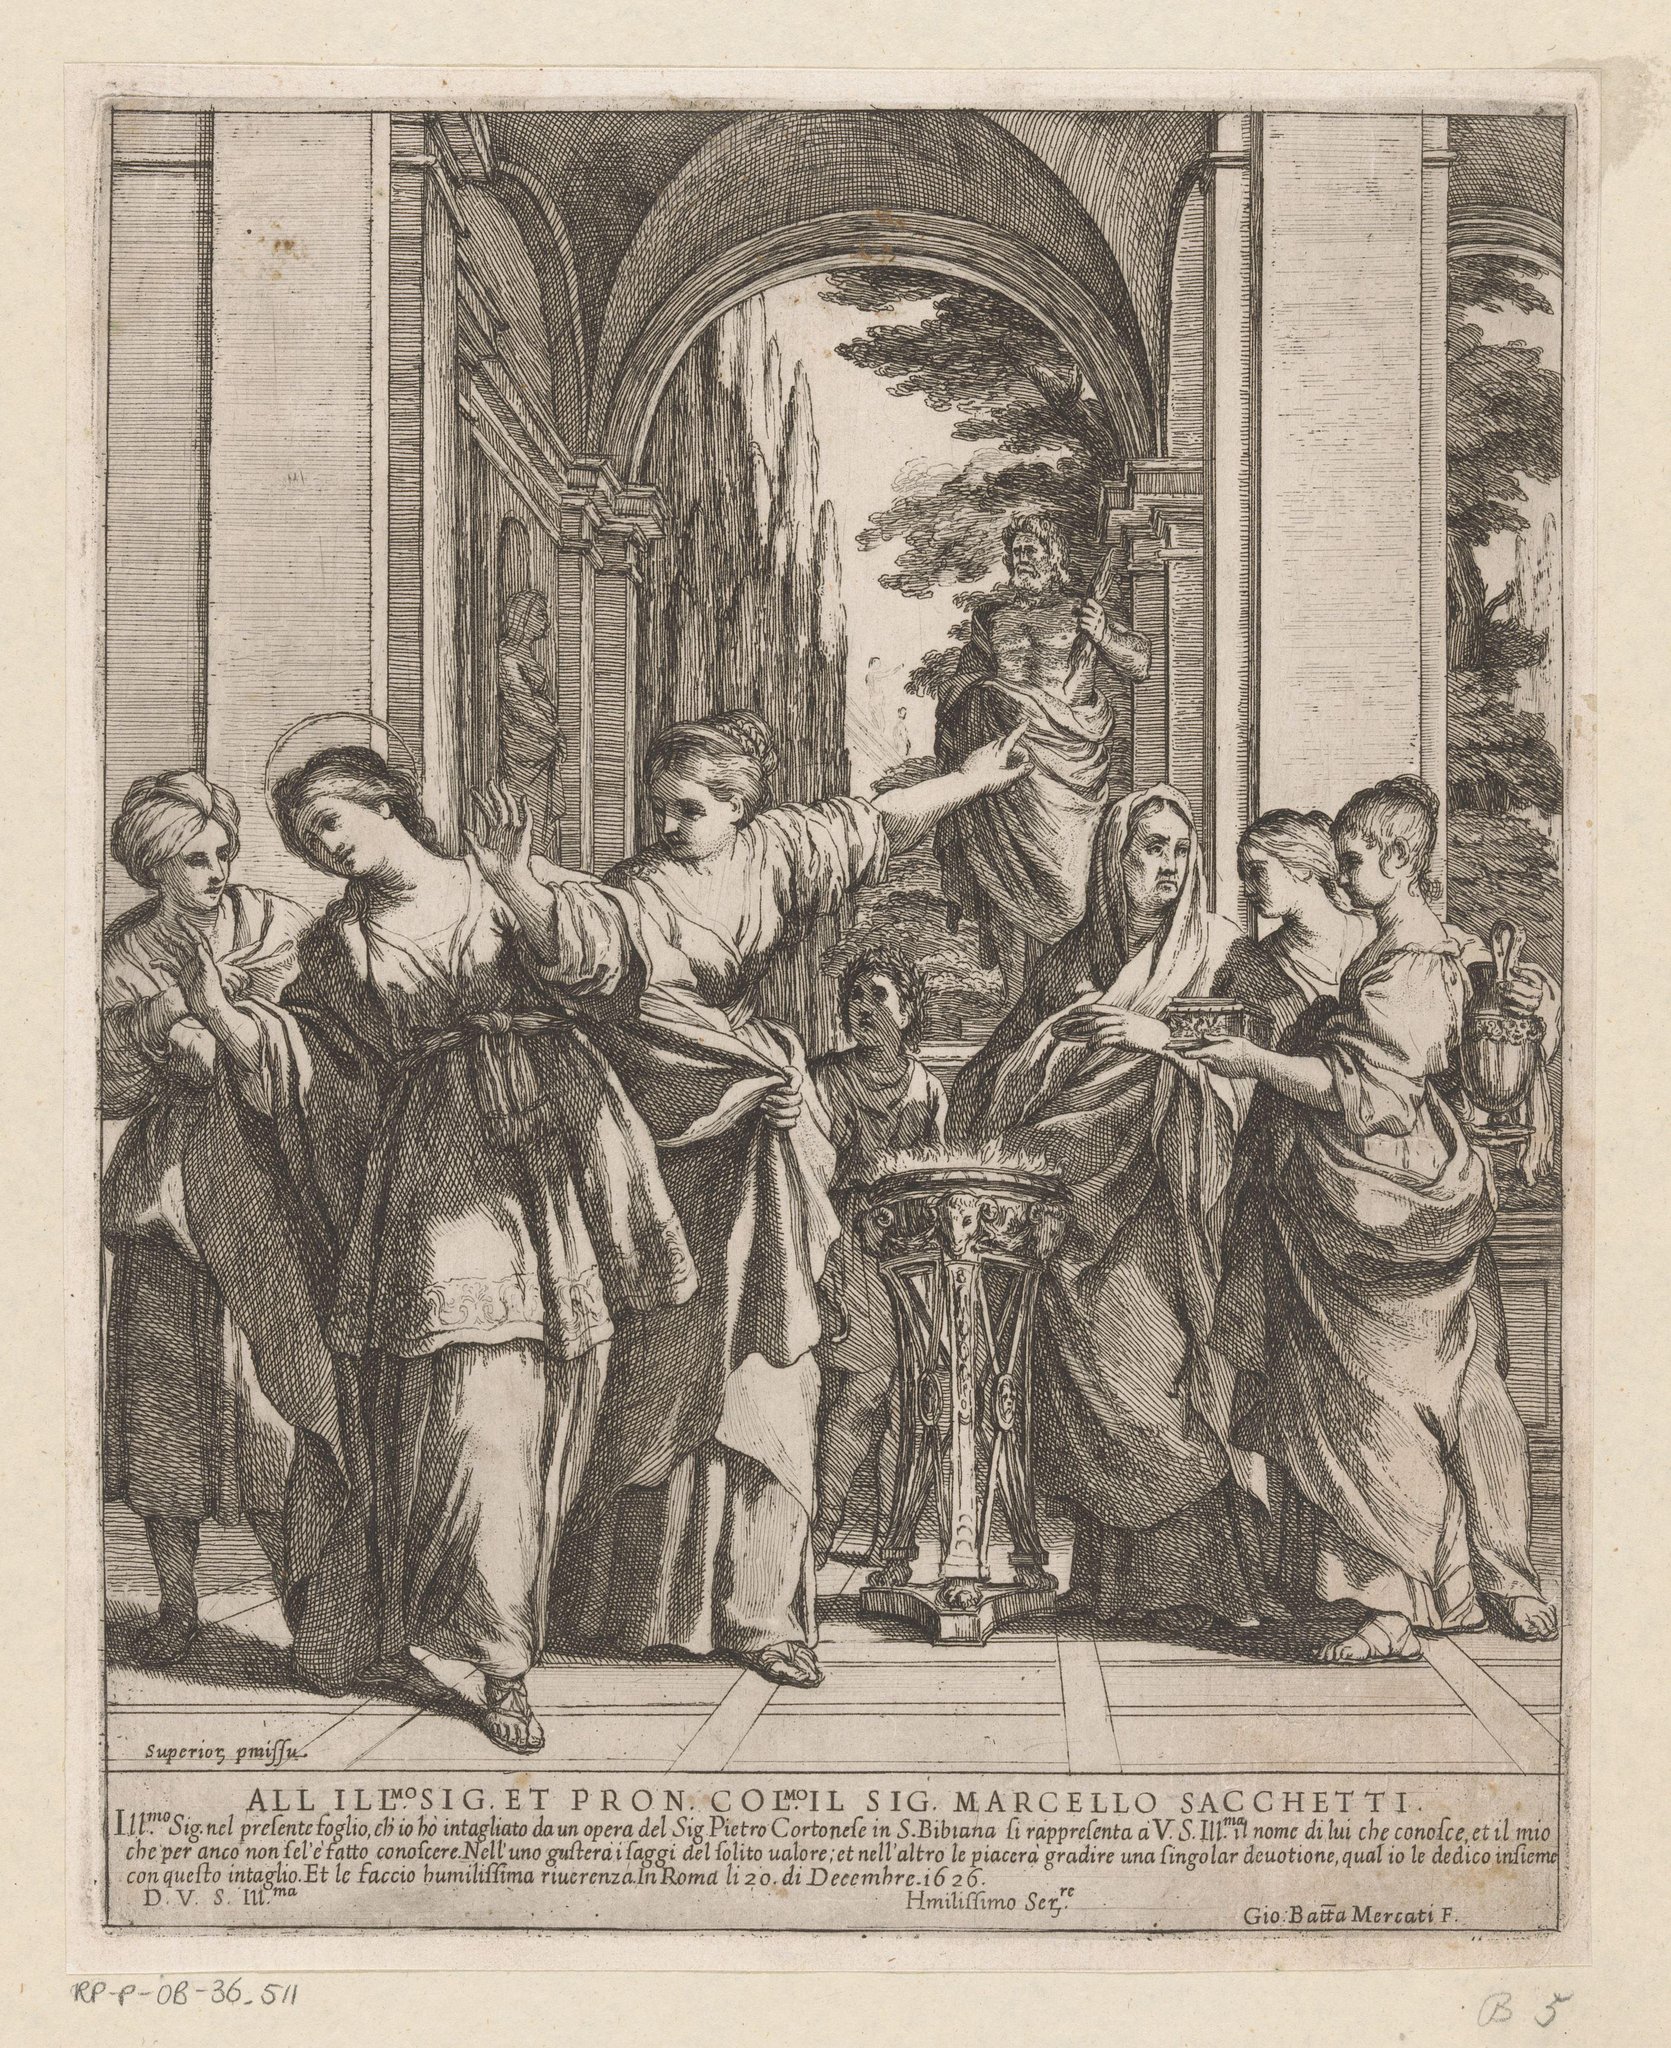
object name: print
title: Heilige Viviane weigert aan de Romeinse goden te offeren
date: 1626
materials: paper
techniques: etching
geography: italy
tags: female saints (with name), sacrifice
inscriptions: collector's mark: Lugt 2228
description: Een groep vrouwen offert aan een beeld van de Romeinse god Jupiter, voor een galerij. De heilige Viviana keert de vrouwen en het beeld de rug toe. Opdracht in ondermarge.